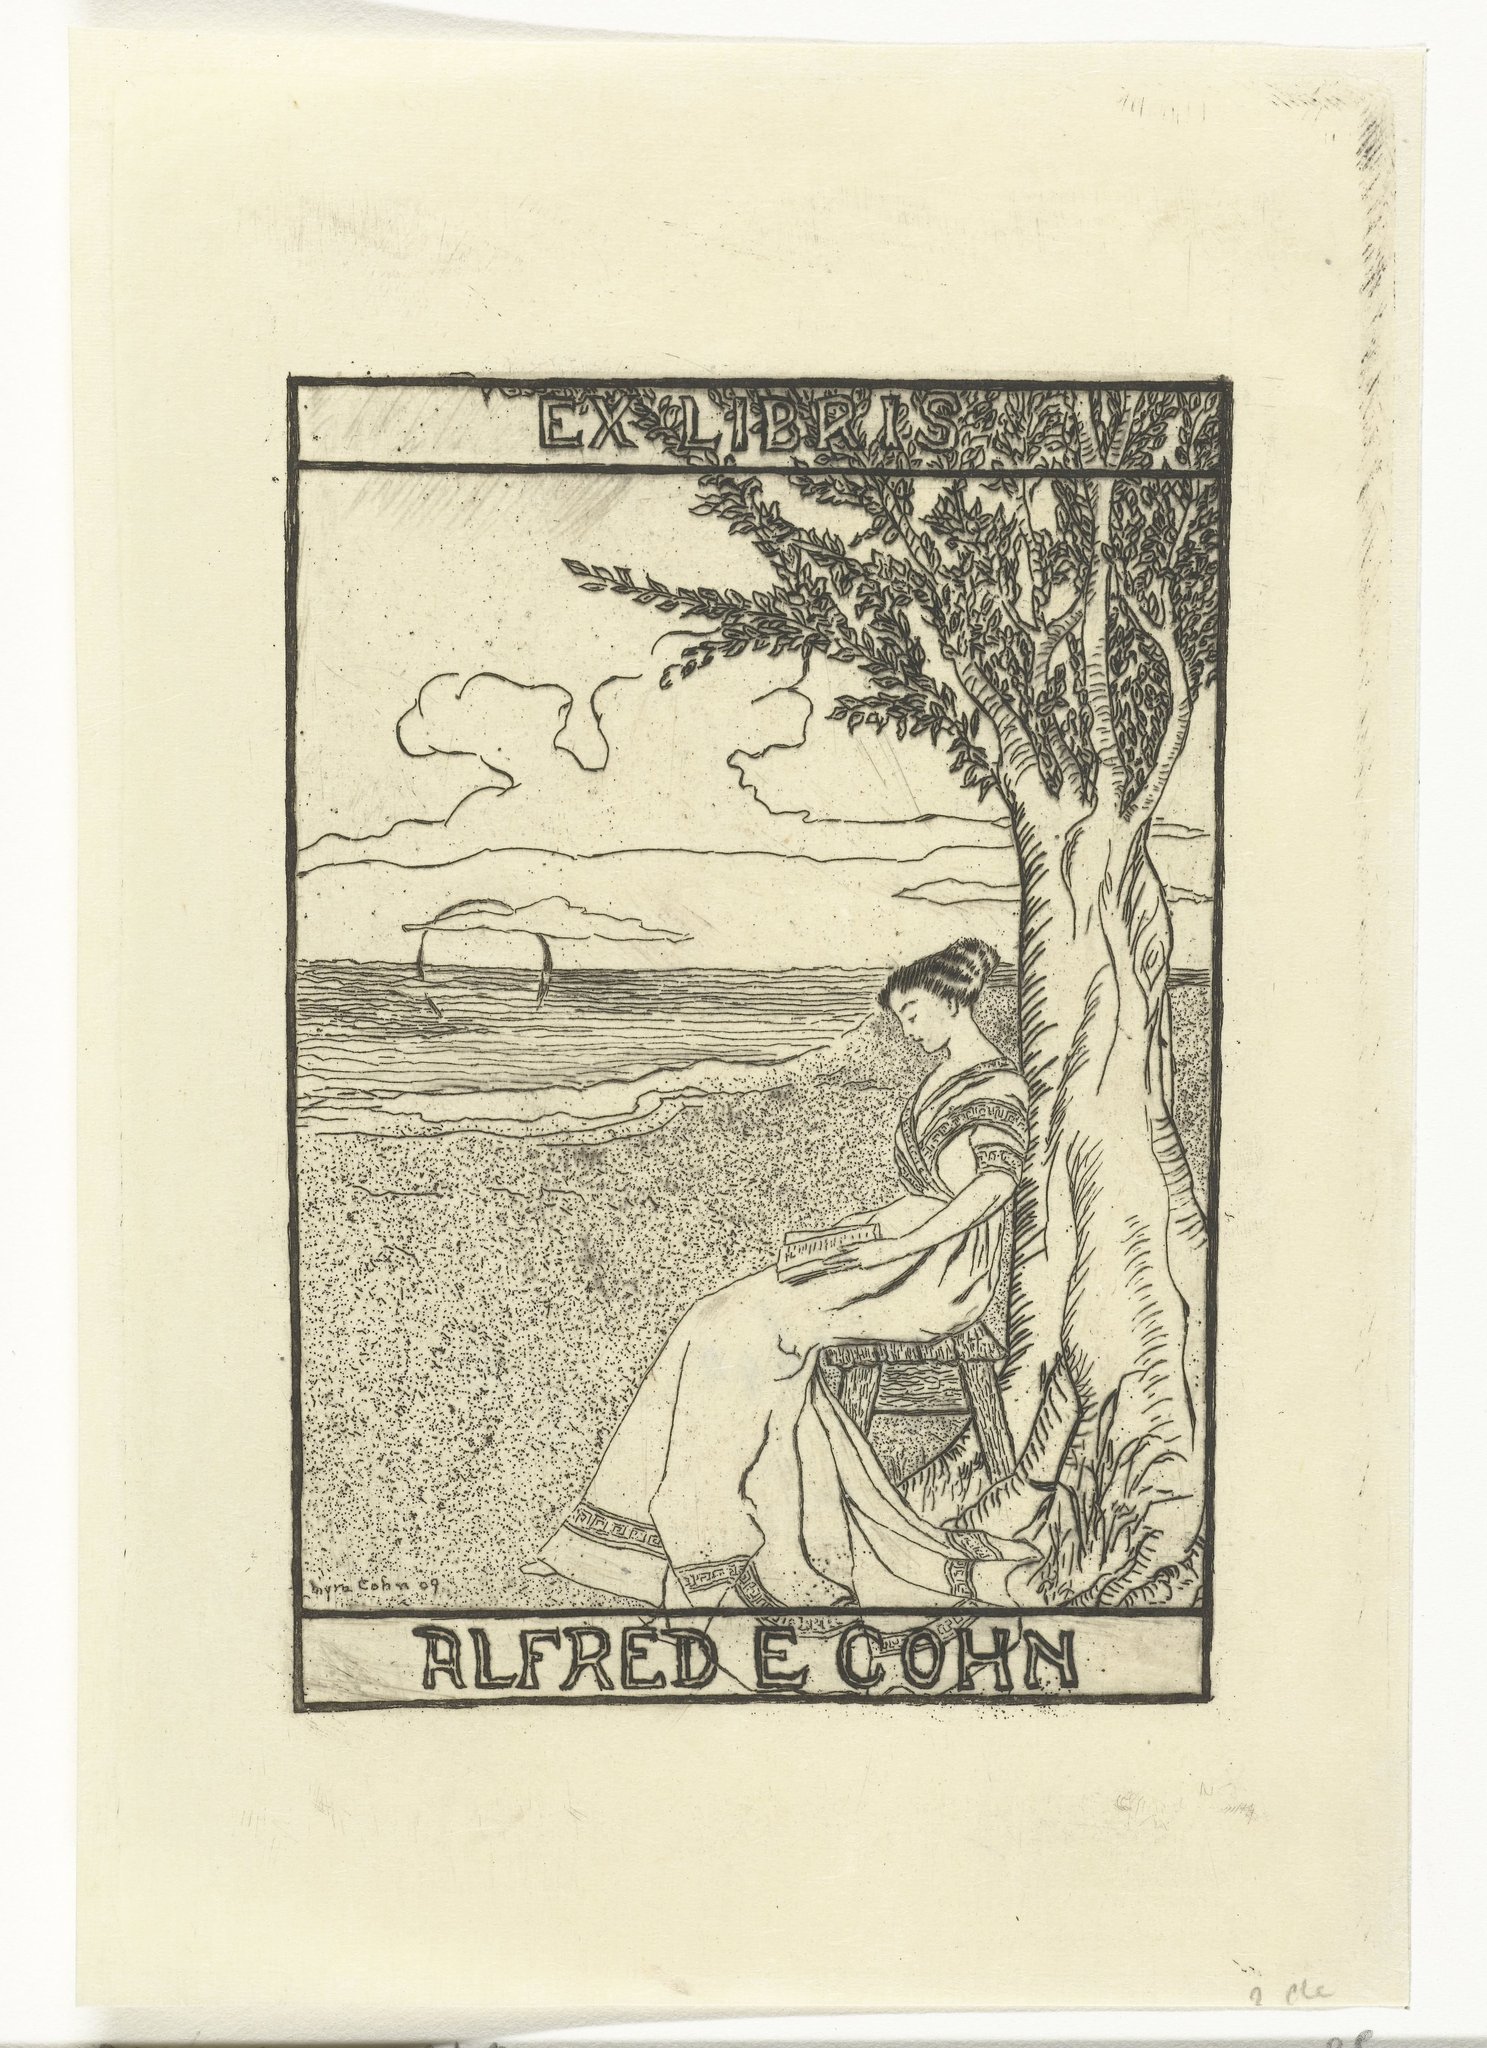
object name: print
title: Ex libris van Alfred E. Cohn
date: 1909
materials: paper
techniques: etching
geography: amsterdam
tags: reading, ex-libris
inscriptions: collector's mark: Lugt 2228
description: Een jonge vrouw zit lezend onder een boom. De zon gaat net onder in de zee.